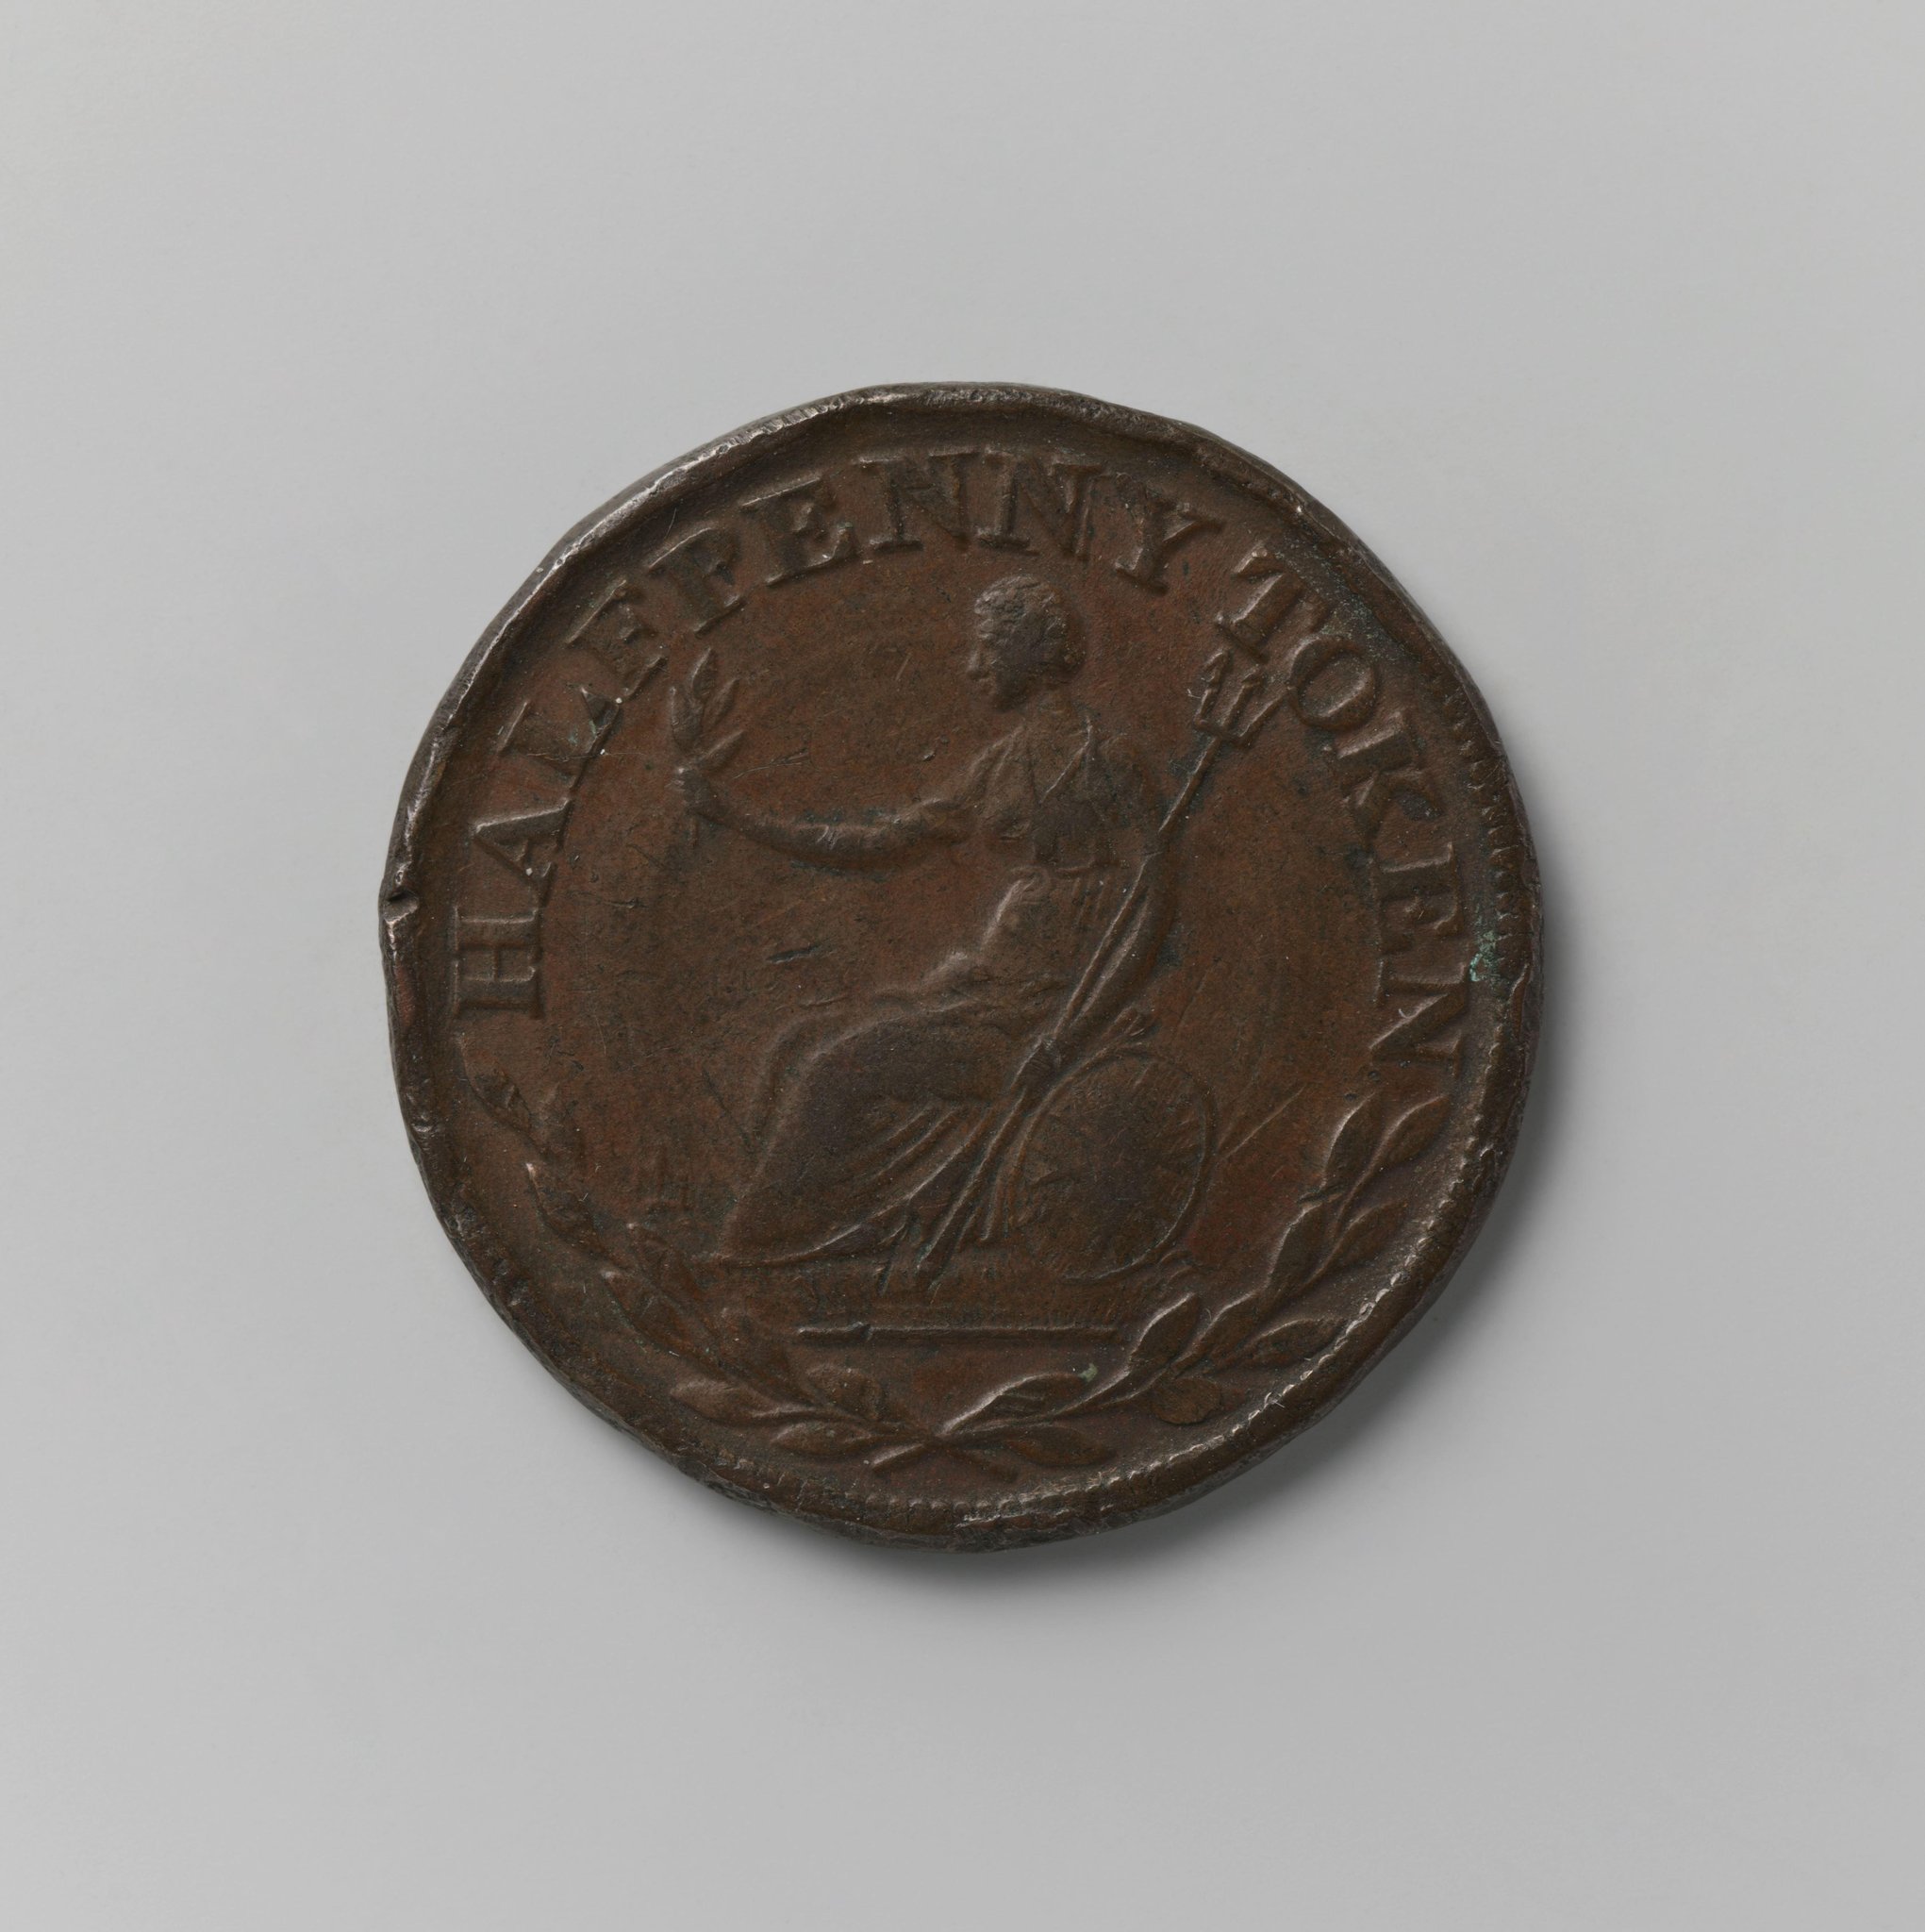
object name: halve penny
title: betaalpenning (token) voor een halve penny uit Engeland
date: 1813-1817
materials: copper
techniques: striking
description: Koperen particuliere munt. Voorzijde: op schild gezeten Brittannnia met drietand en takken, naar links. Daarboven waarde-aanduiding. Keerzijde: gelauwerd borstbeeld van Welllington naar links. Daaronder twee gekruiste lauriertakkken. Kabelrand.